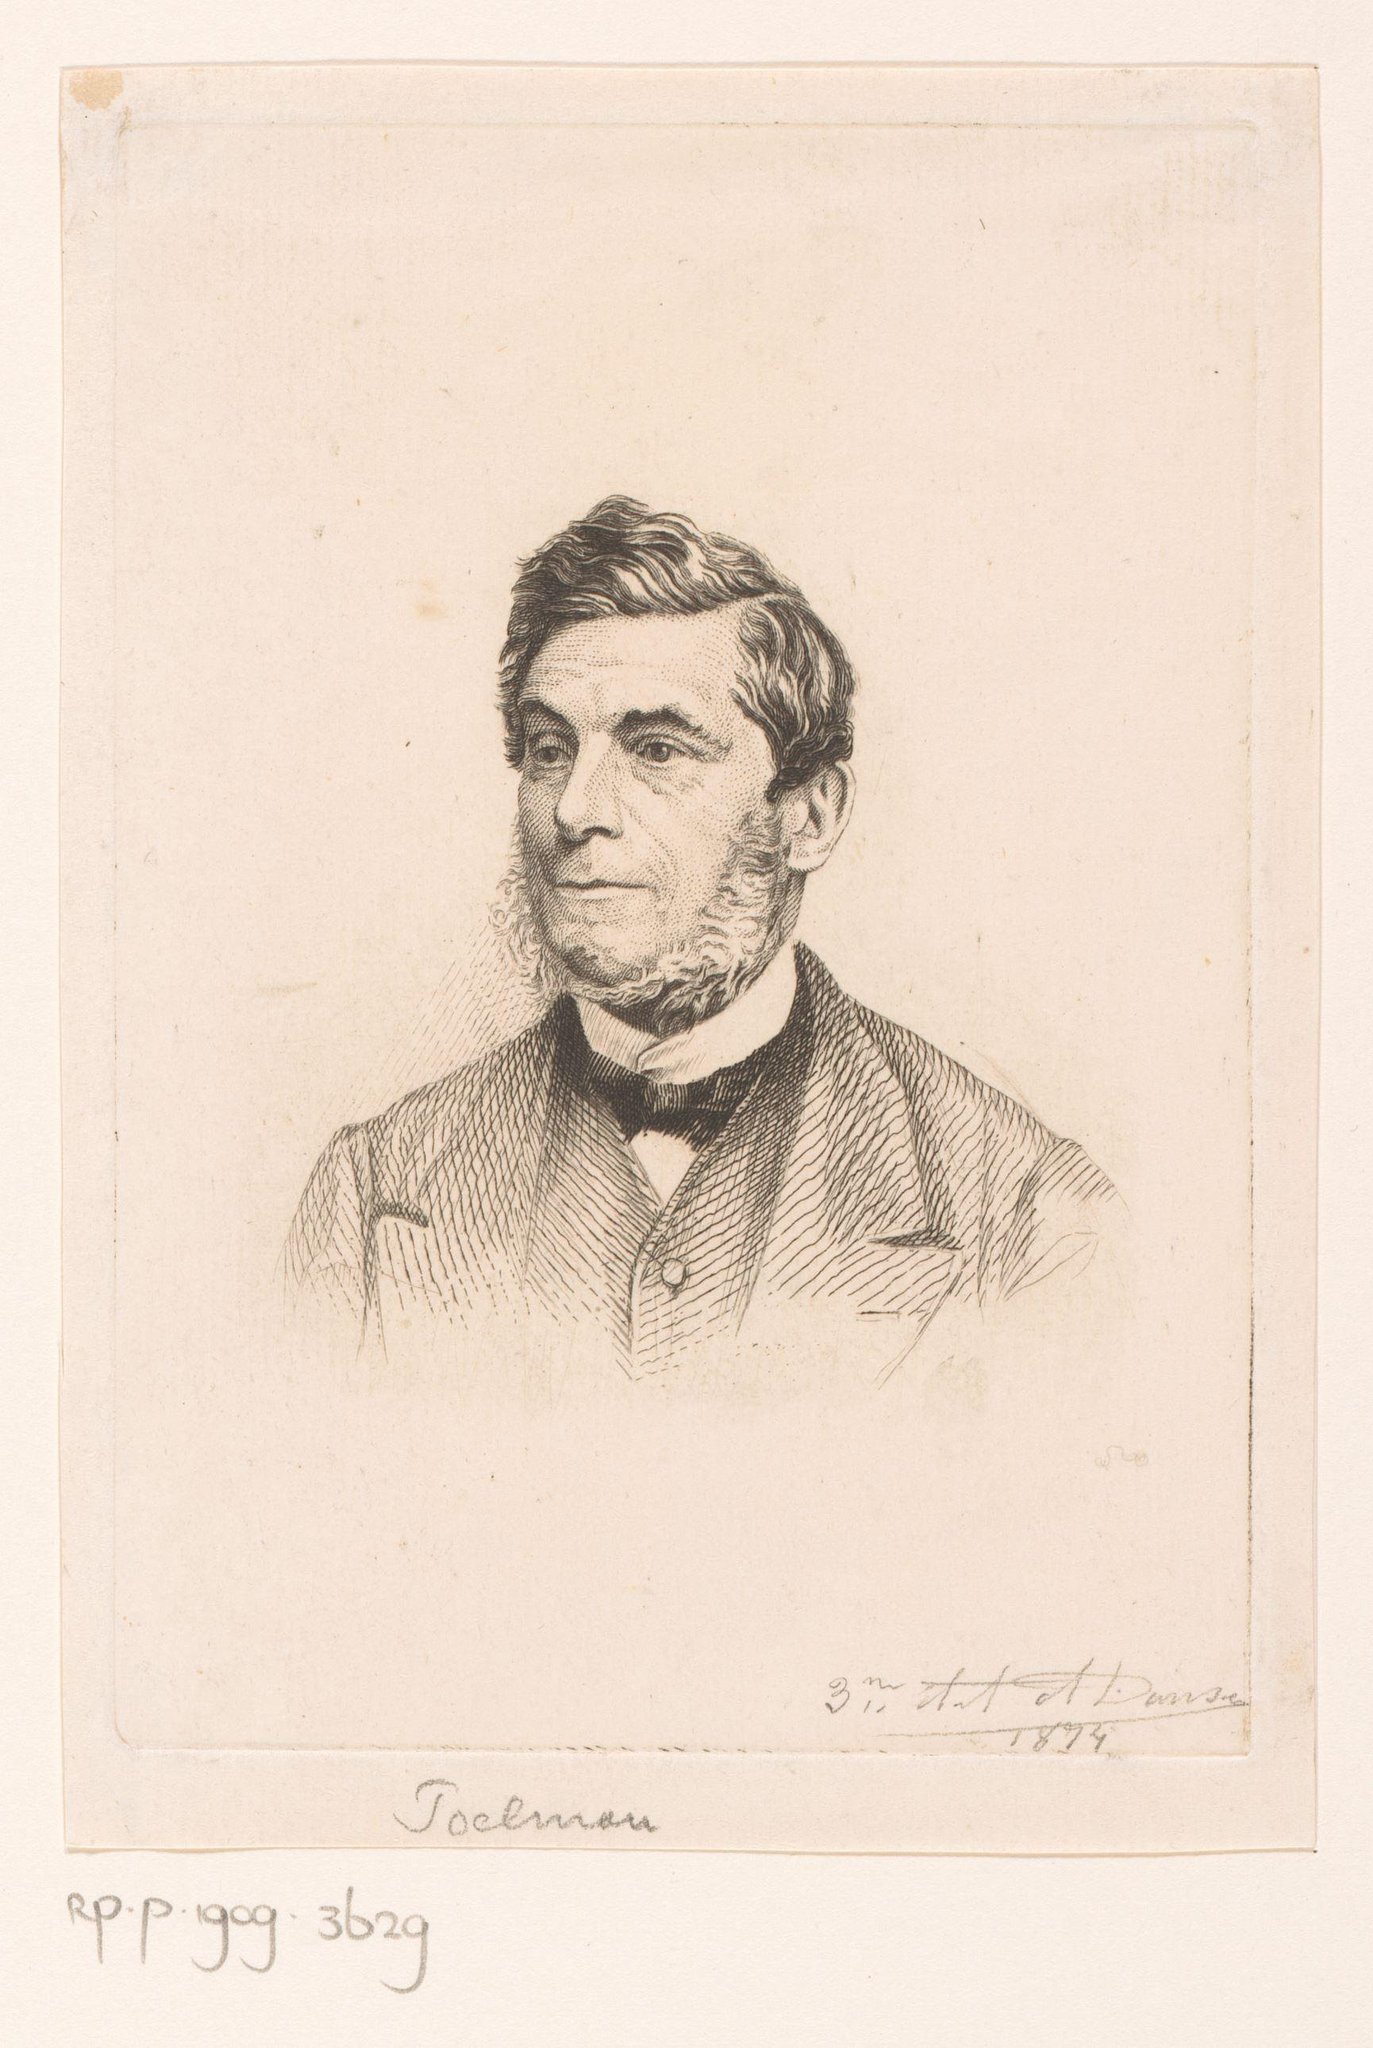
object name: print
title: Portret van de heer Poelman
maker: auguste danse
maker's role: print maker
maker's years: 1829-1929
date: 1874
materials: paper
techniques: etching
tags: anonymous historical person portrayed alone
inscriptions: annotation: ‘3me etat’, collector's mark: Lugt 2228